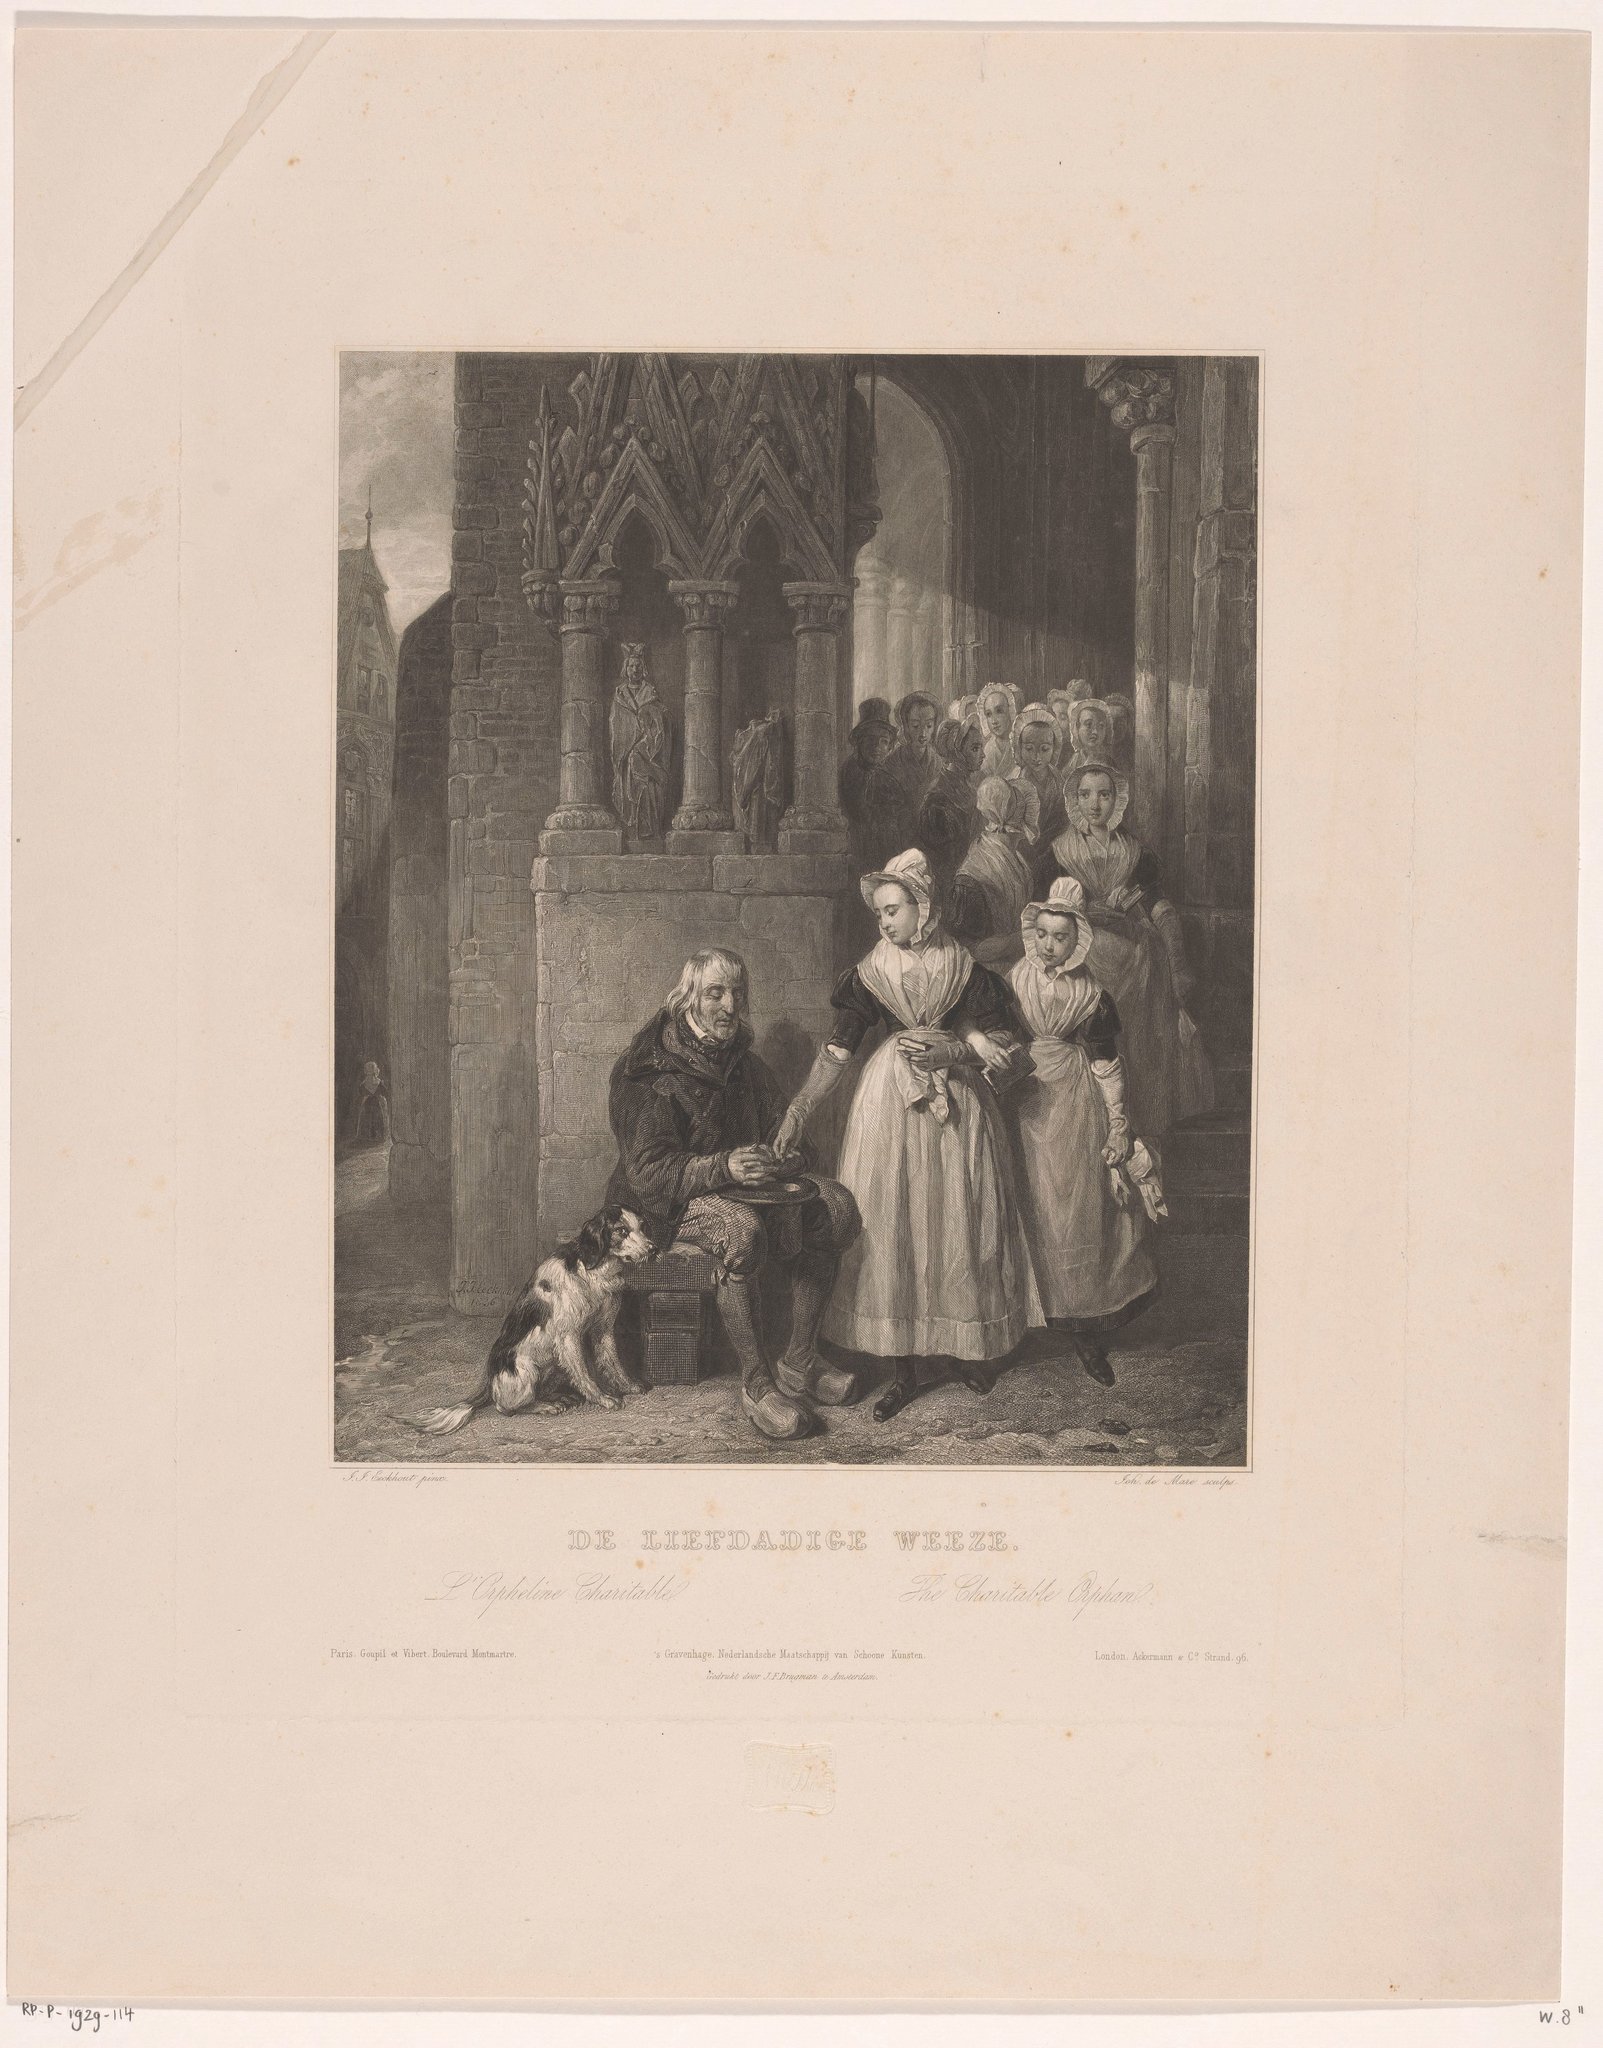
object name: print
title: De Liefdadige Weeze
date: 1840-1843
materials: paper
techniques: engraving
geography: paris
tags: parts of church exterior and annexes: portal, beggar, giving alms; collection, orphans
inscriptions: collector's mark: Lugt 2233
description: Bij het uitgaan van een kerkmis lopen vele weesmeisjes door een kerkportaal. De voorste van hen geeft een aalmoes aan een bedelaar met naast hem een hond.